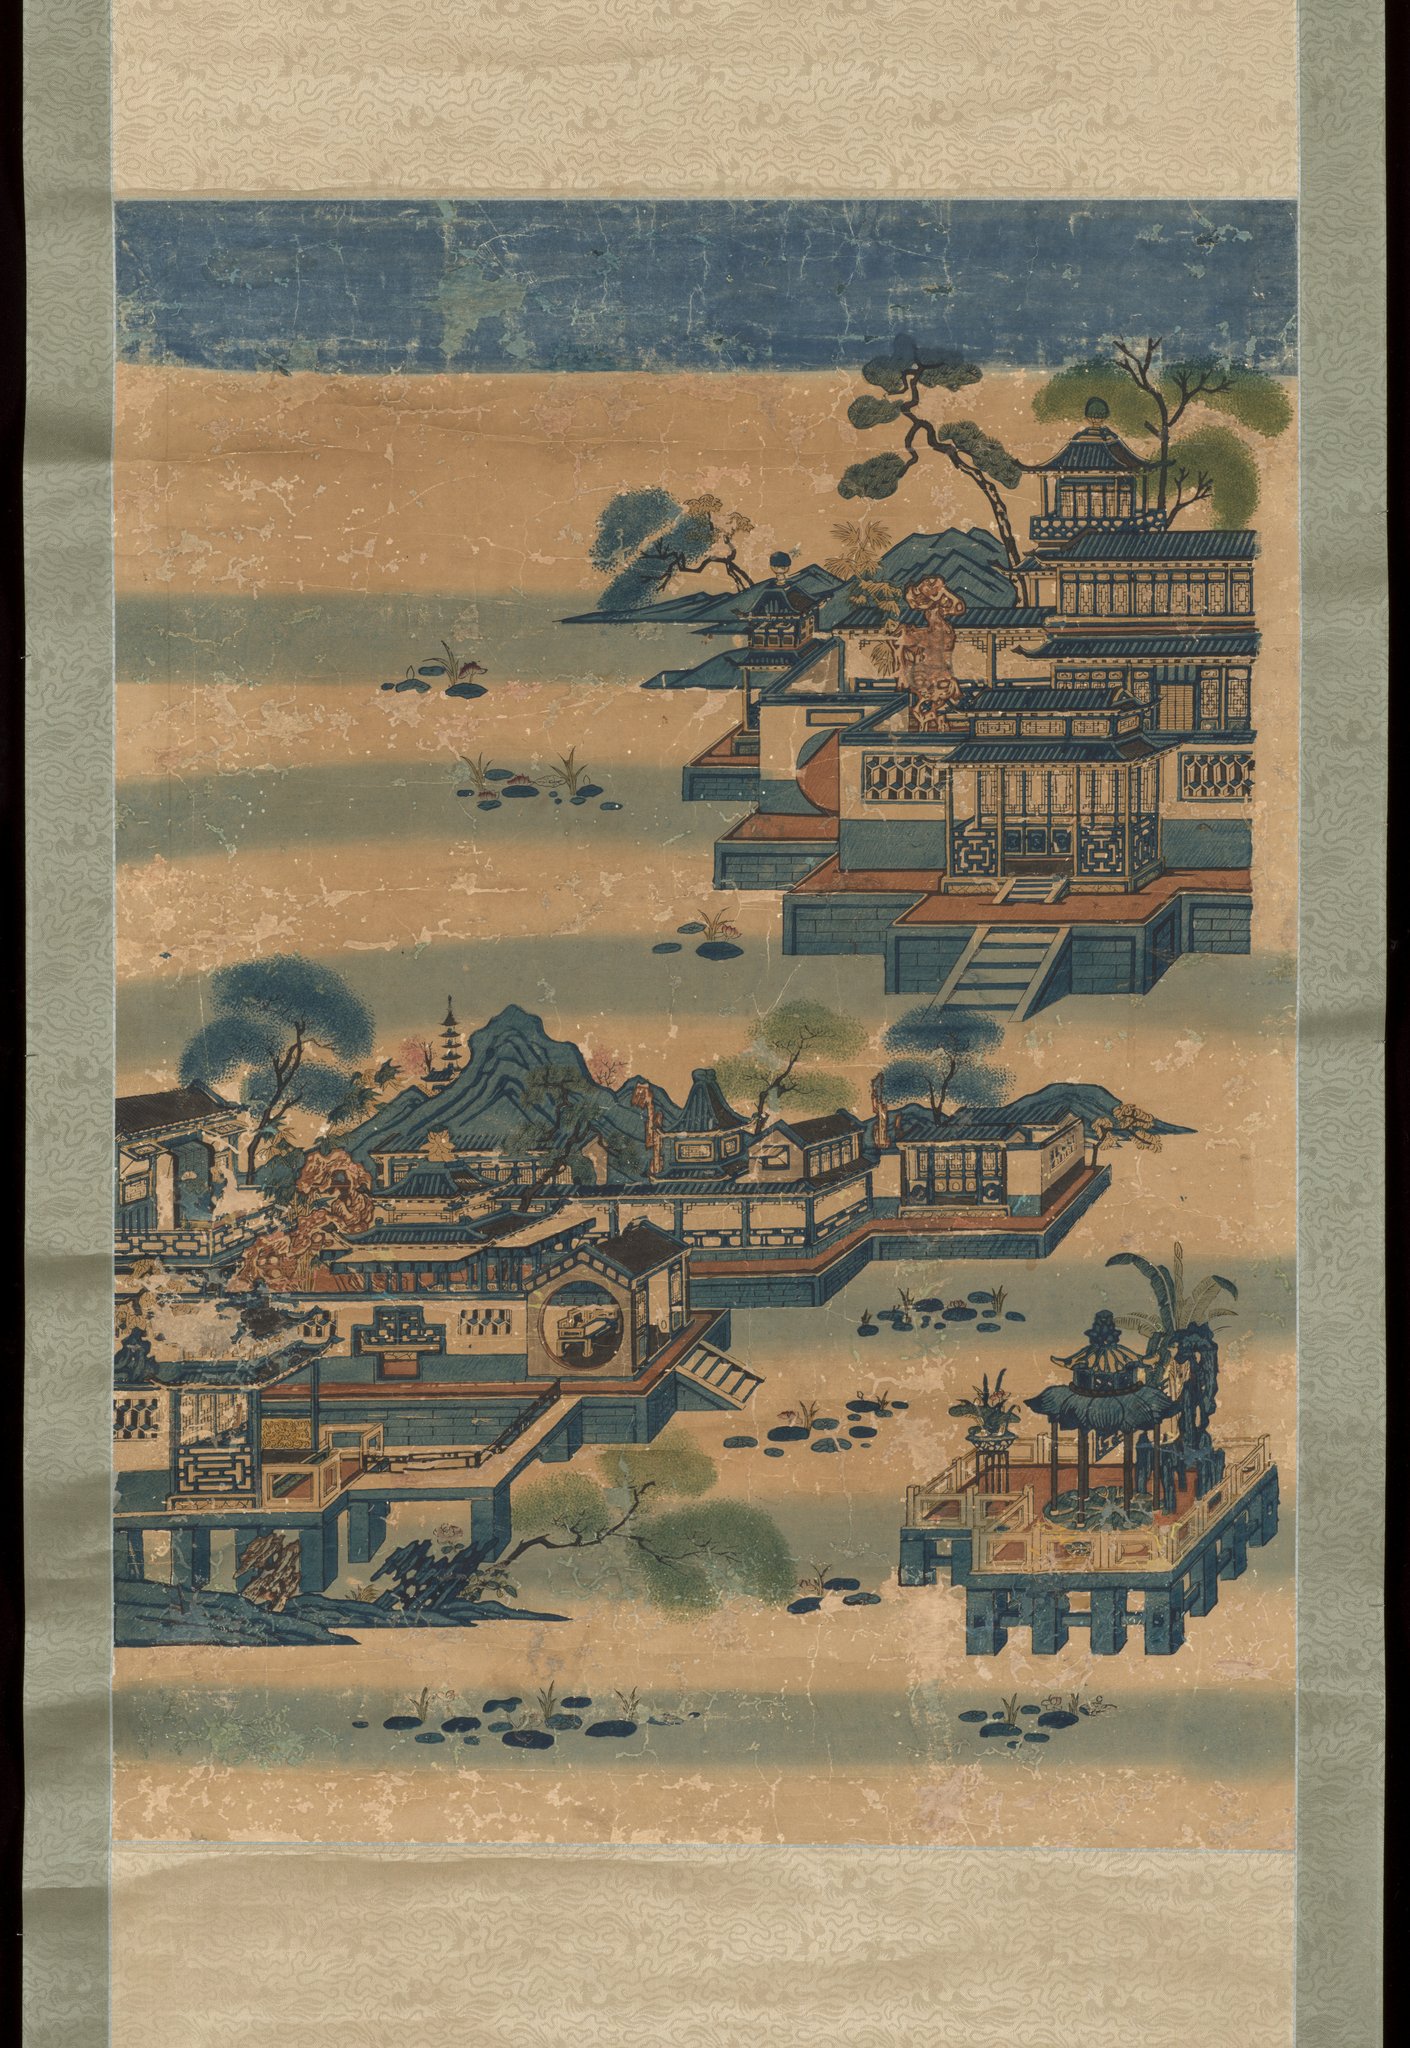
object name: print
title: Scenic Spots of Zhenjiang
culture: chinese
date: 1736-1795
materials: ink, paper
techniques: hand coloring, woodblock print